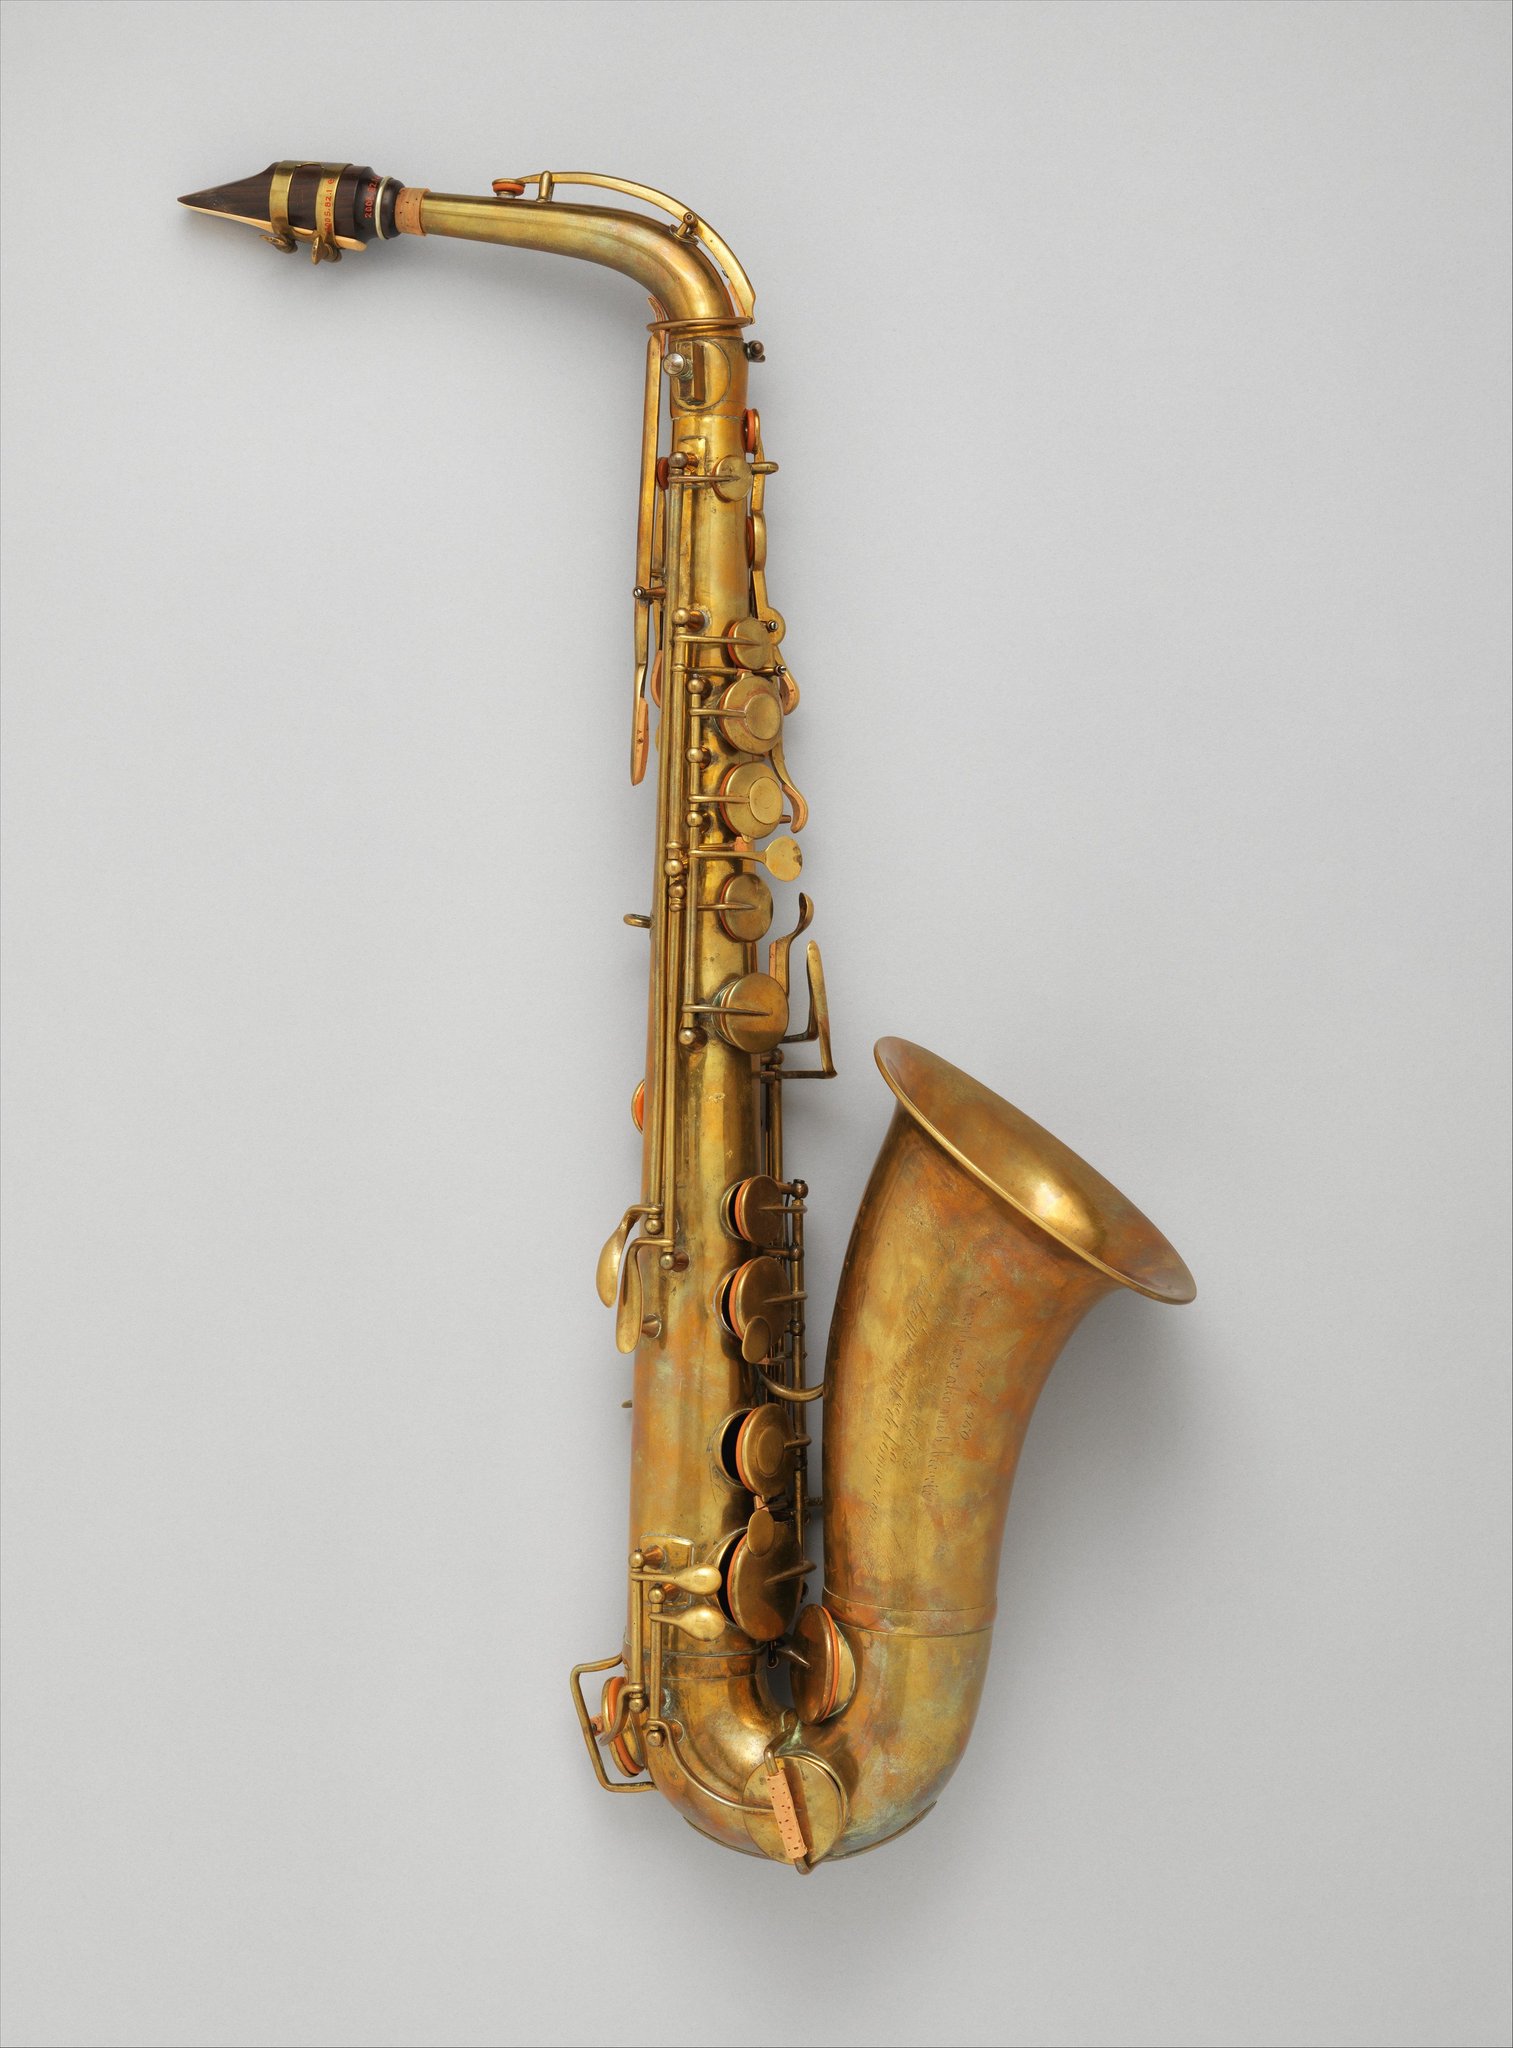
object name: alto saxophone in e flat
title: Alto saxophone in E-flat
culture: french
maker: adolphe (antoine joseph) sax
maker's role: maker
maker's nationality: belgian, active france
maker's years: 1814-1894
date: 1855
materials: brass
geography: france